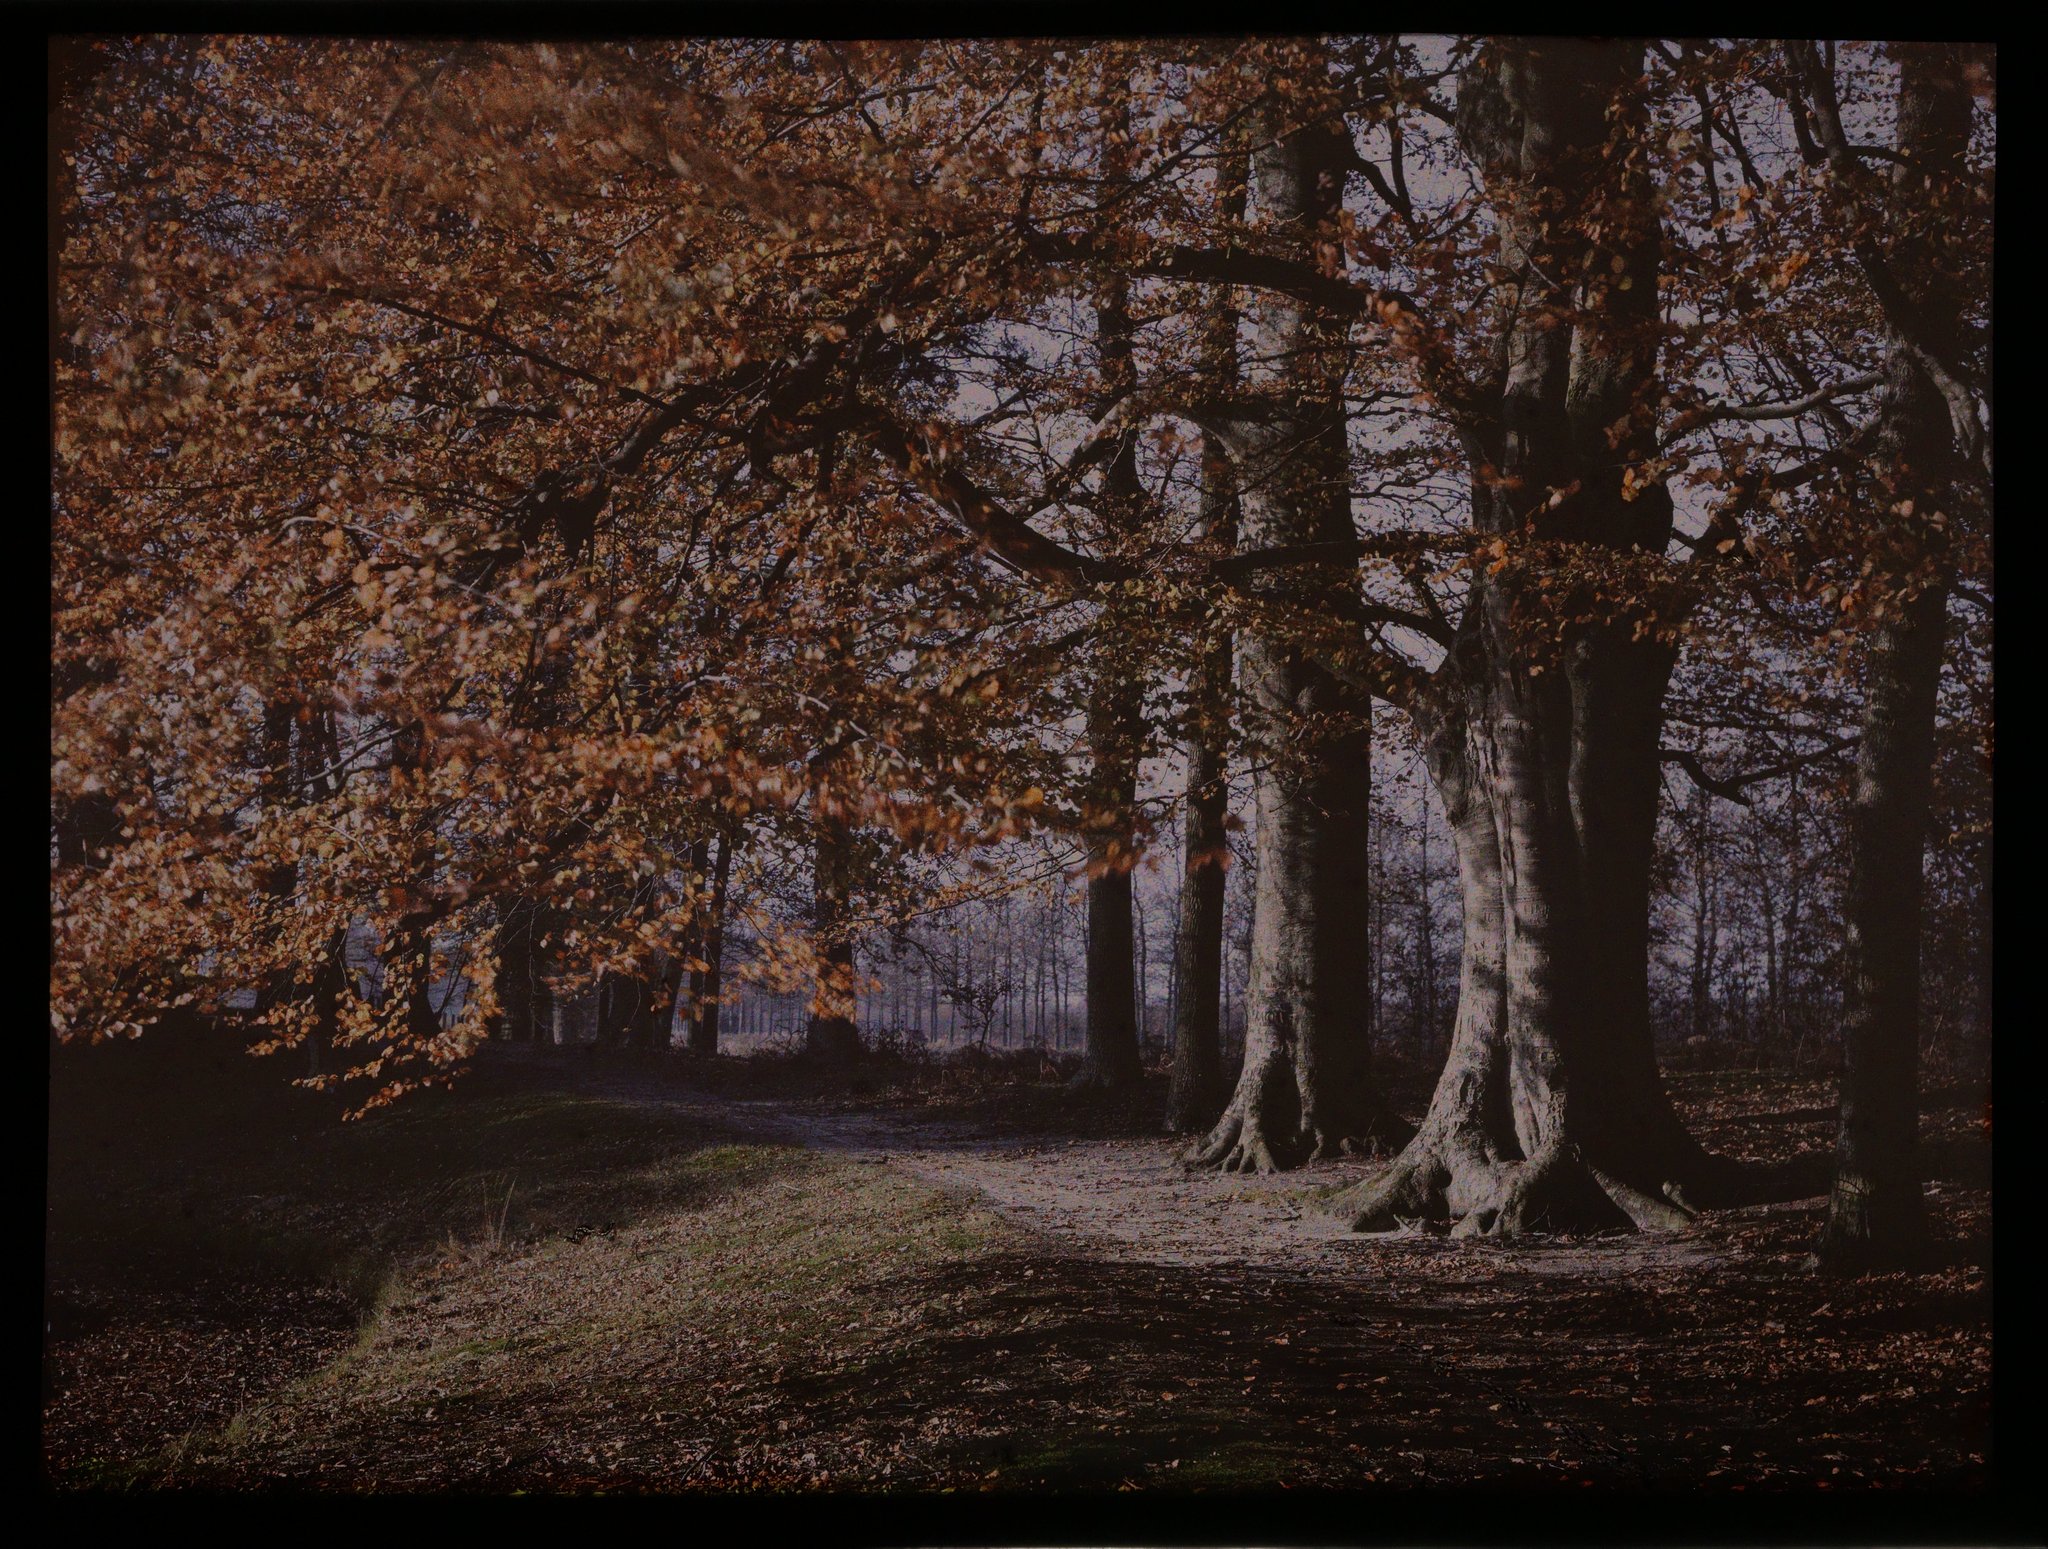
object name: photograph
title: Boslandschap in herfst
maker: Anonymous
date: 1907-1935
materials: glass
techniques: autochrome process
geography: netherlands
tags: netherlands